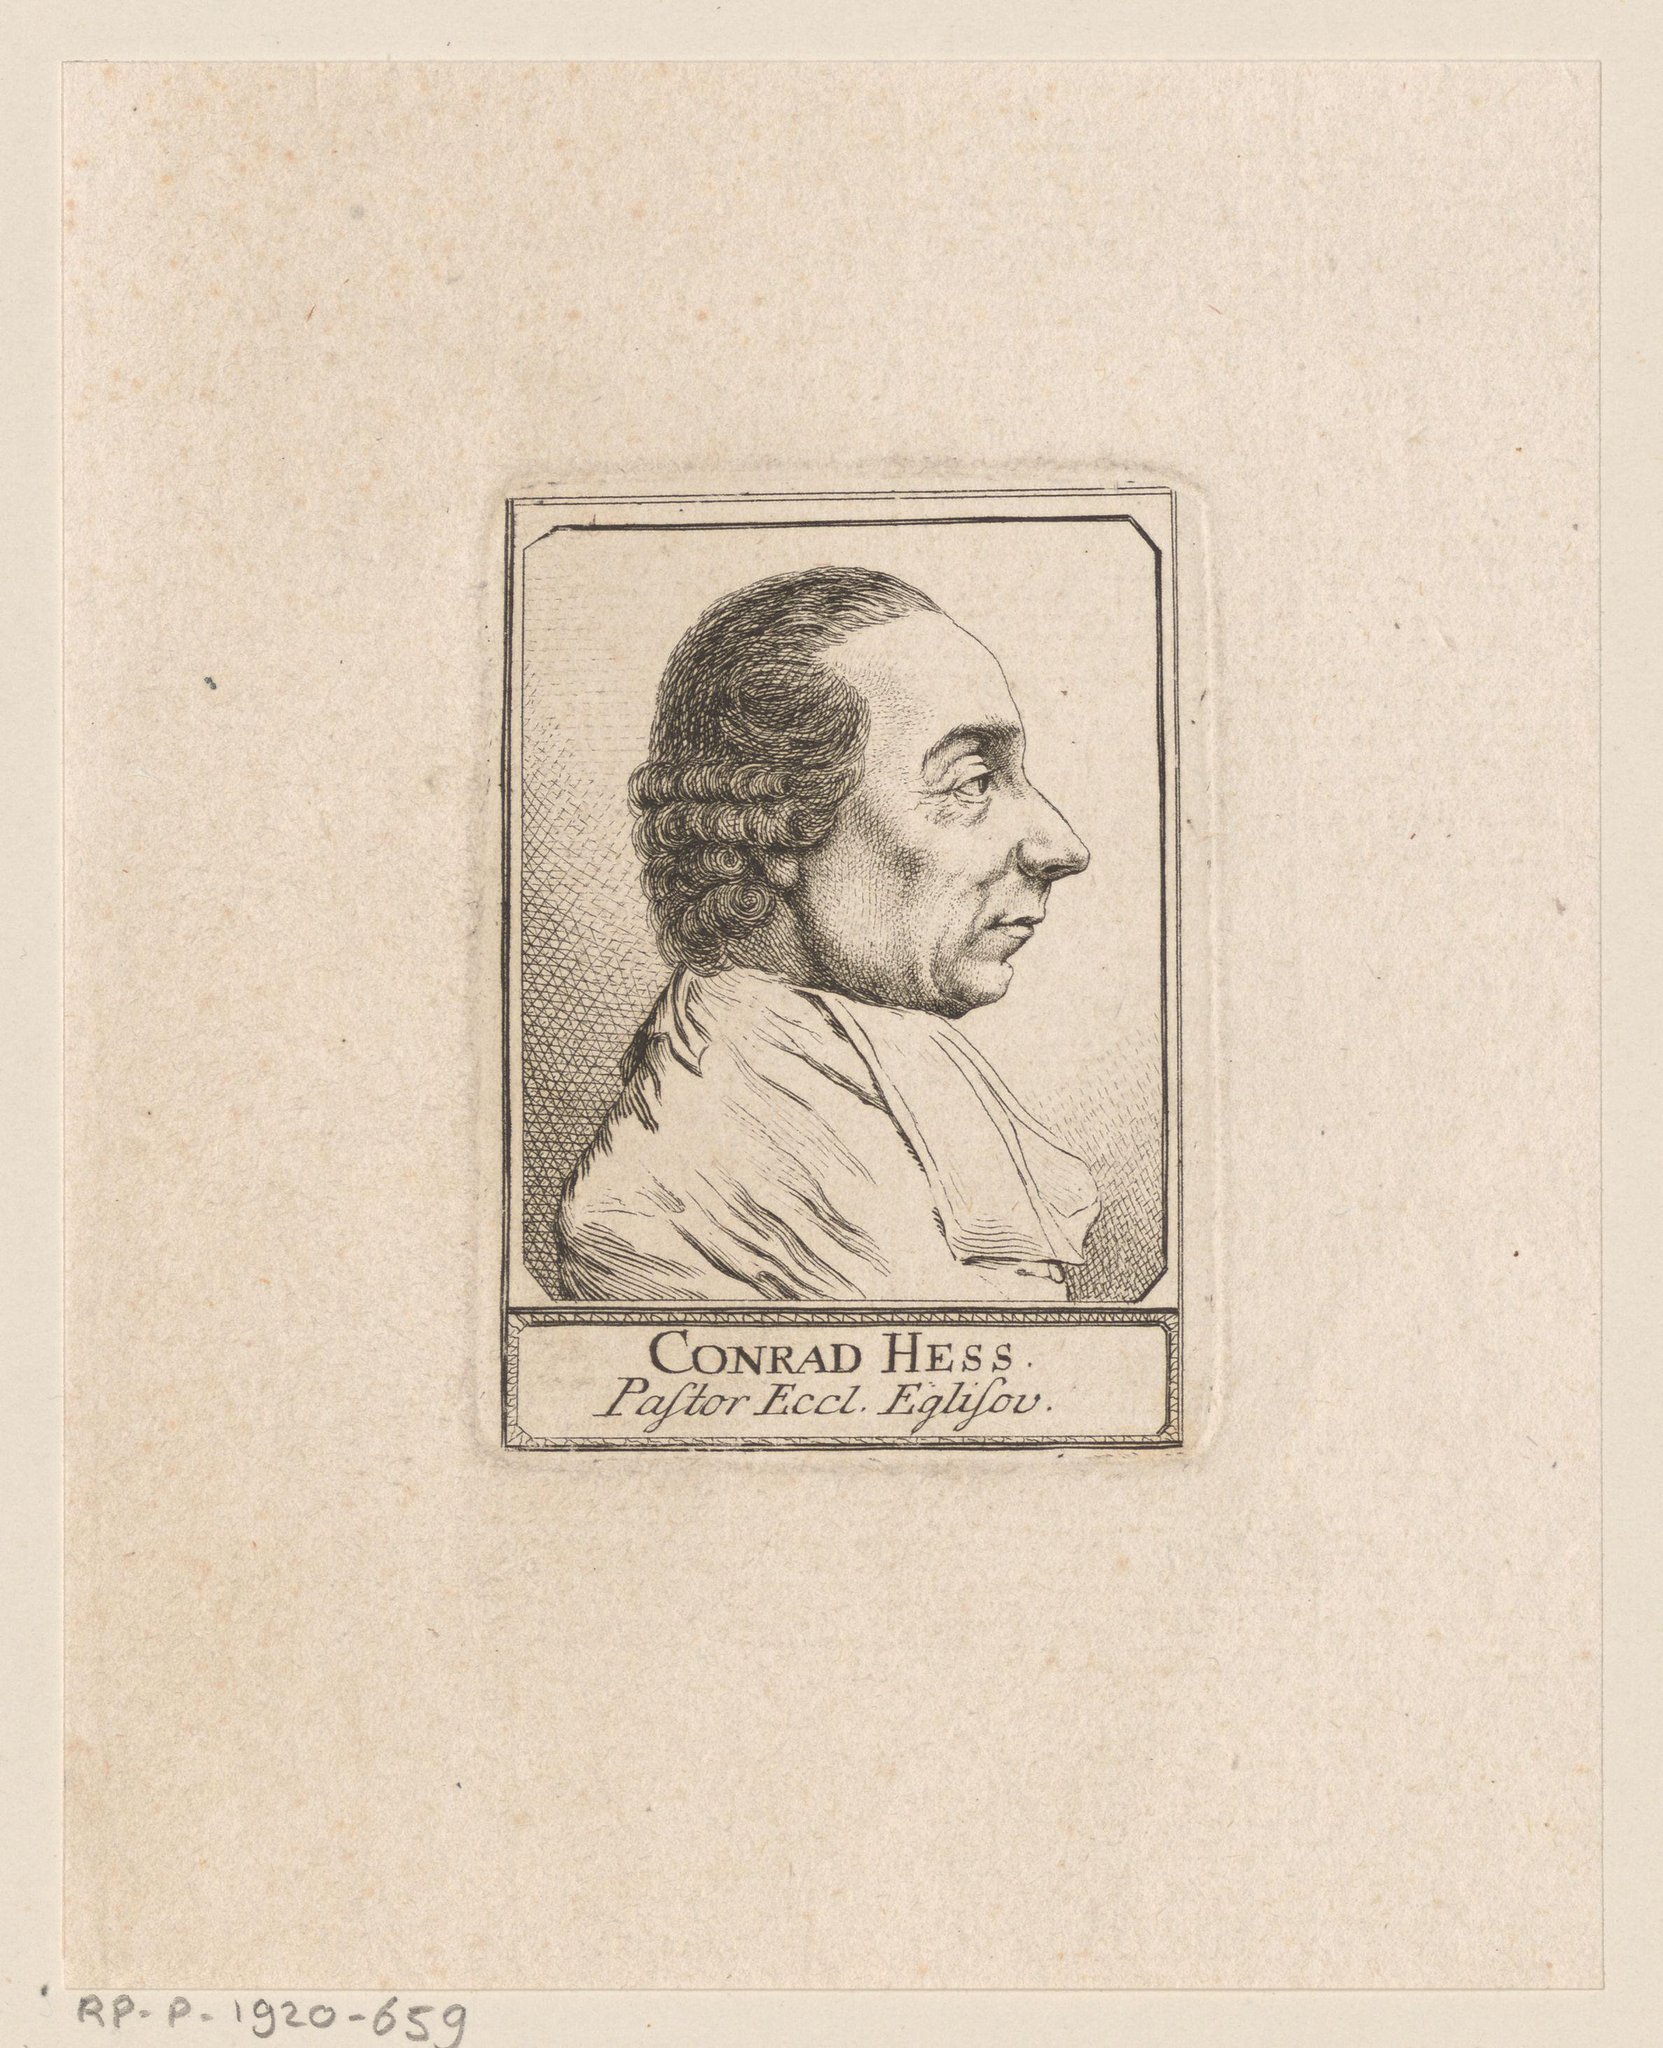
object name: print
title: Portret van Conrad Hess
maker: Anonymous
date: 1750-1799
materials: paper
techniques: engraving, etching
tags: historical persons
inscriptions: collector's mark: Lugt 2228